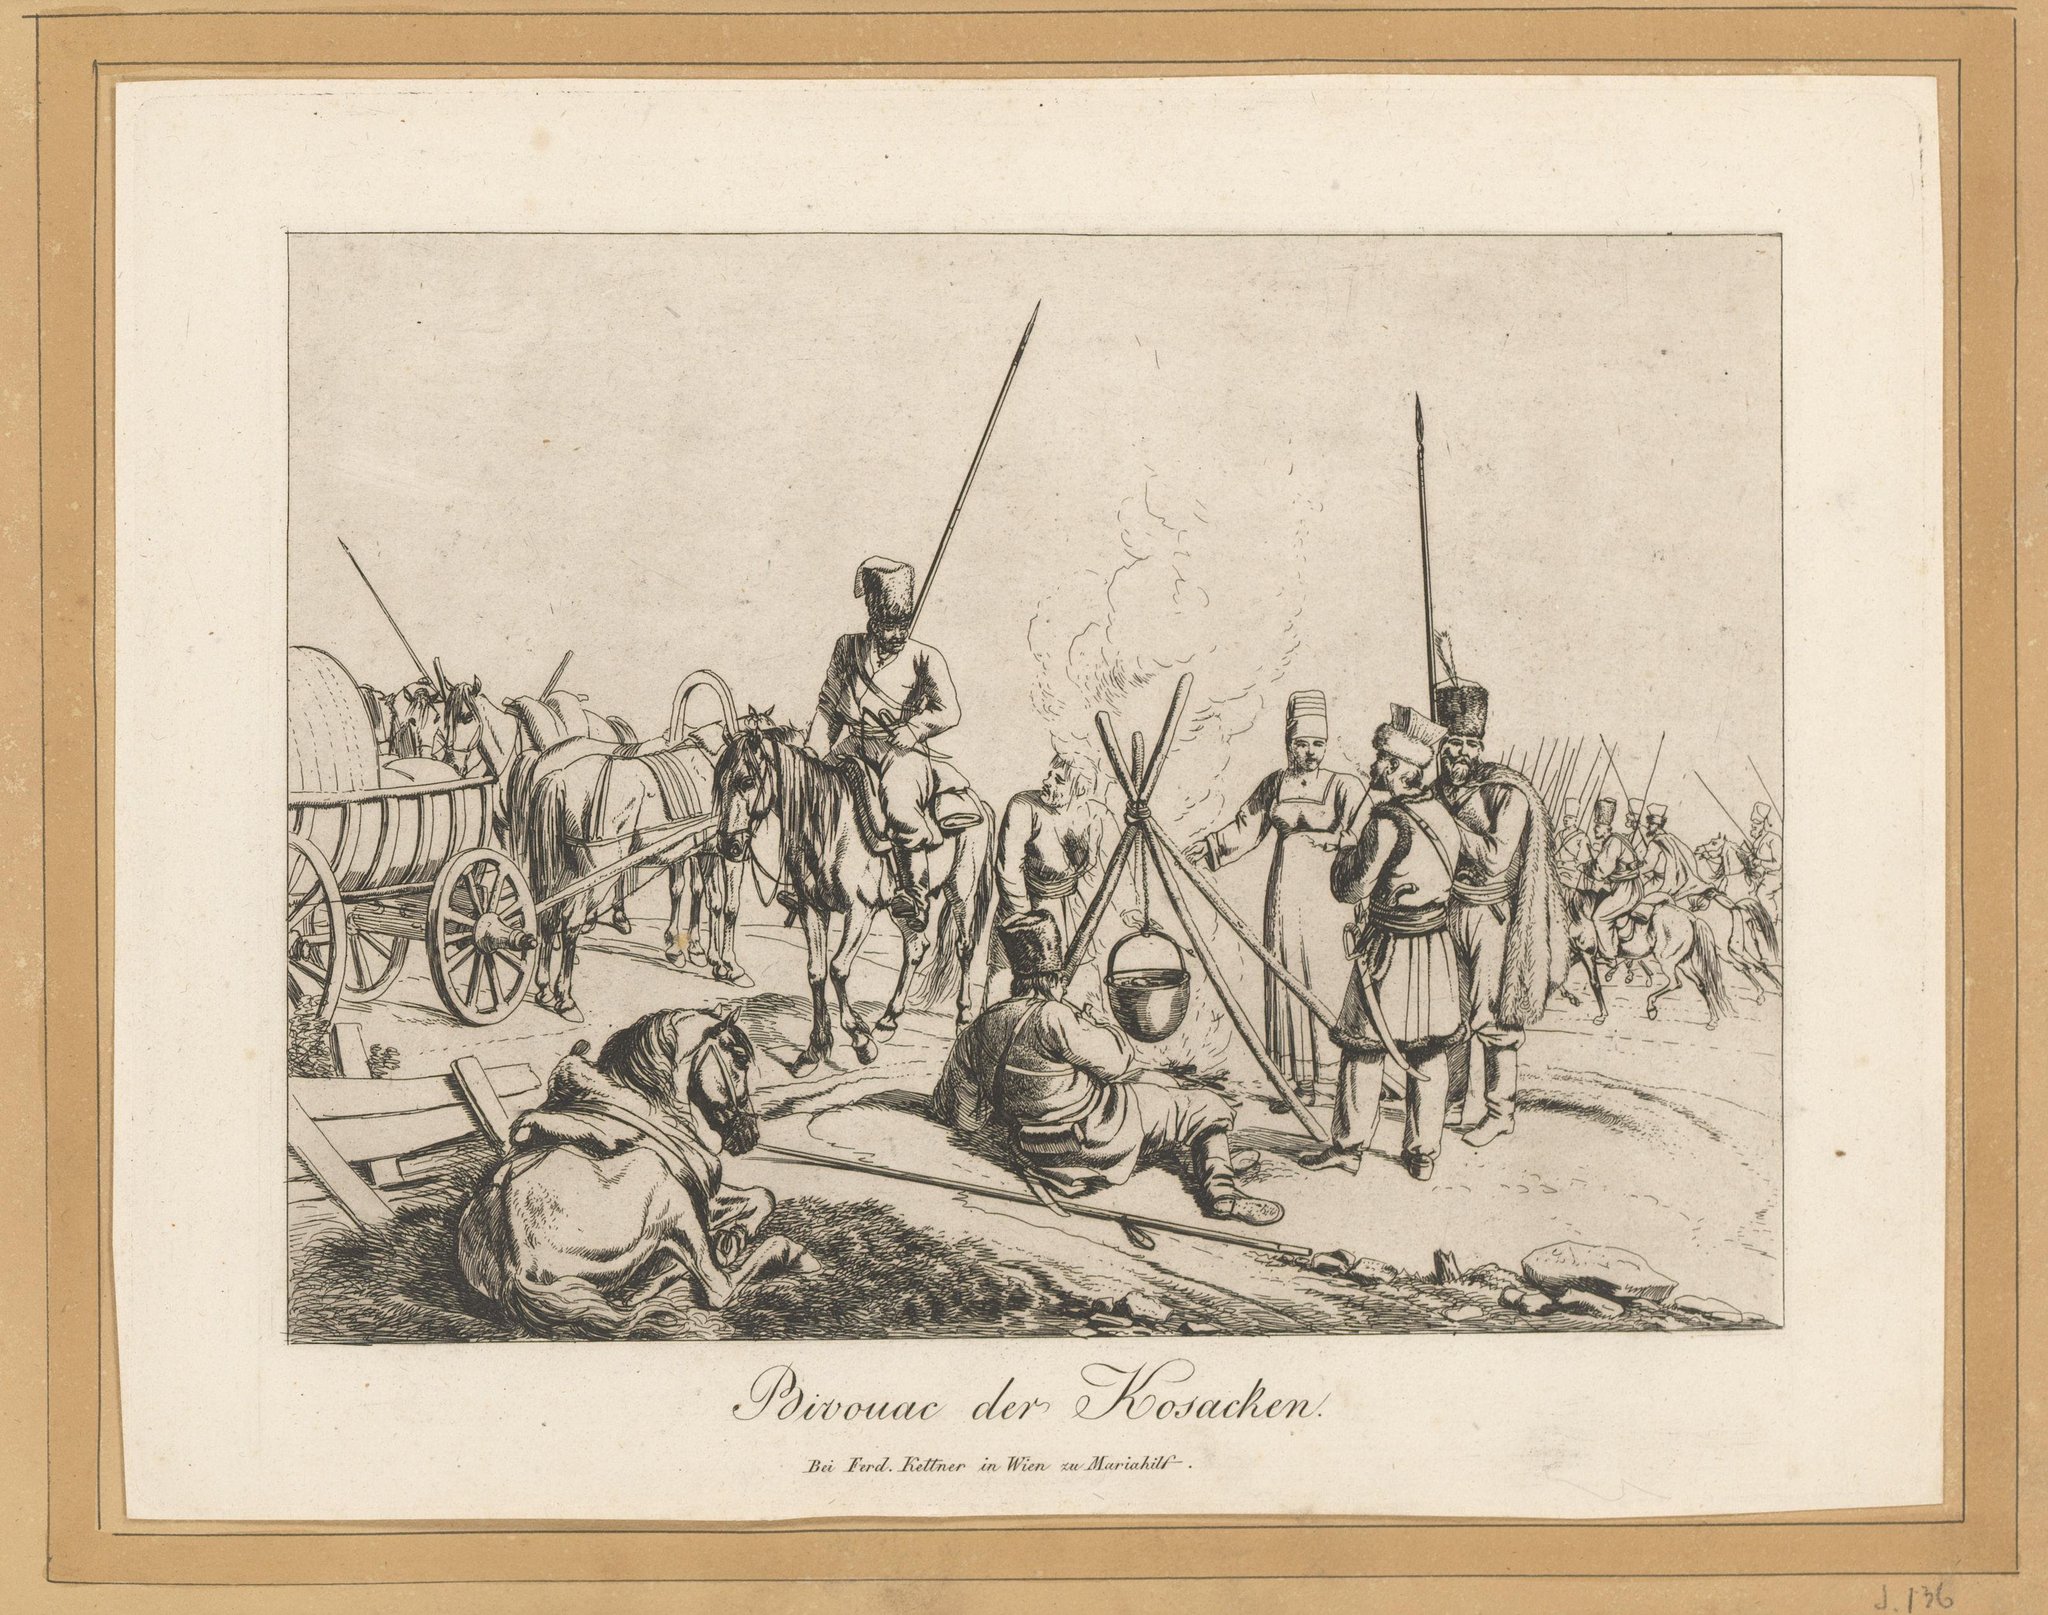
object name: print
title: Bivouac der Kosacken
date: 1808-1814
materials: paper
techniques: etching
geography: vienna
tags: (military) camp with tents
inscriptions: collector's mark: Lugt 2228, : Lugt 2760